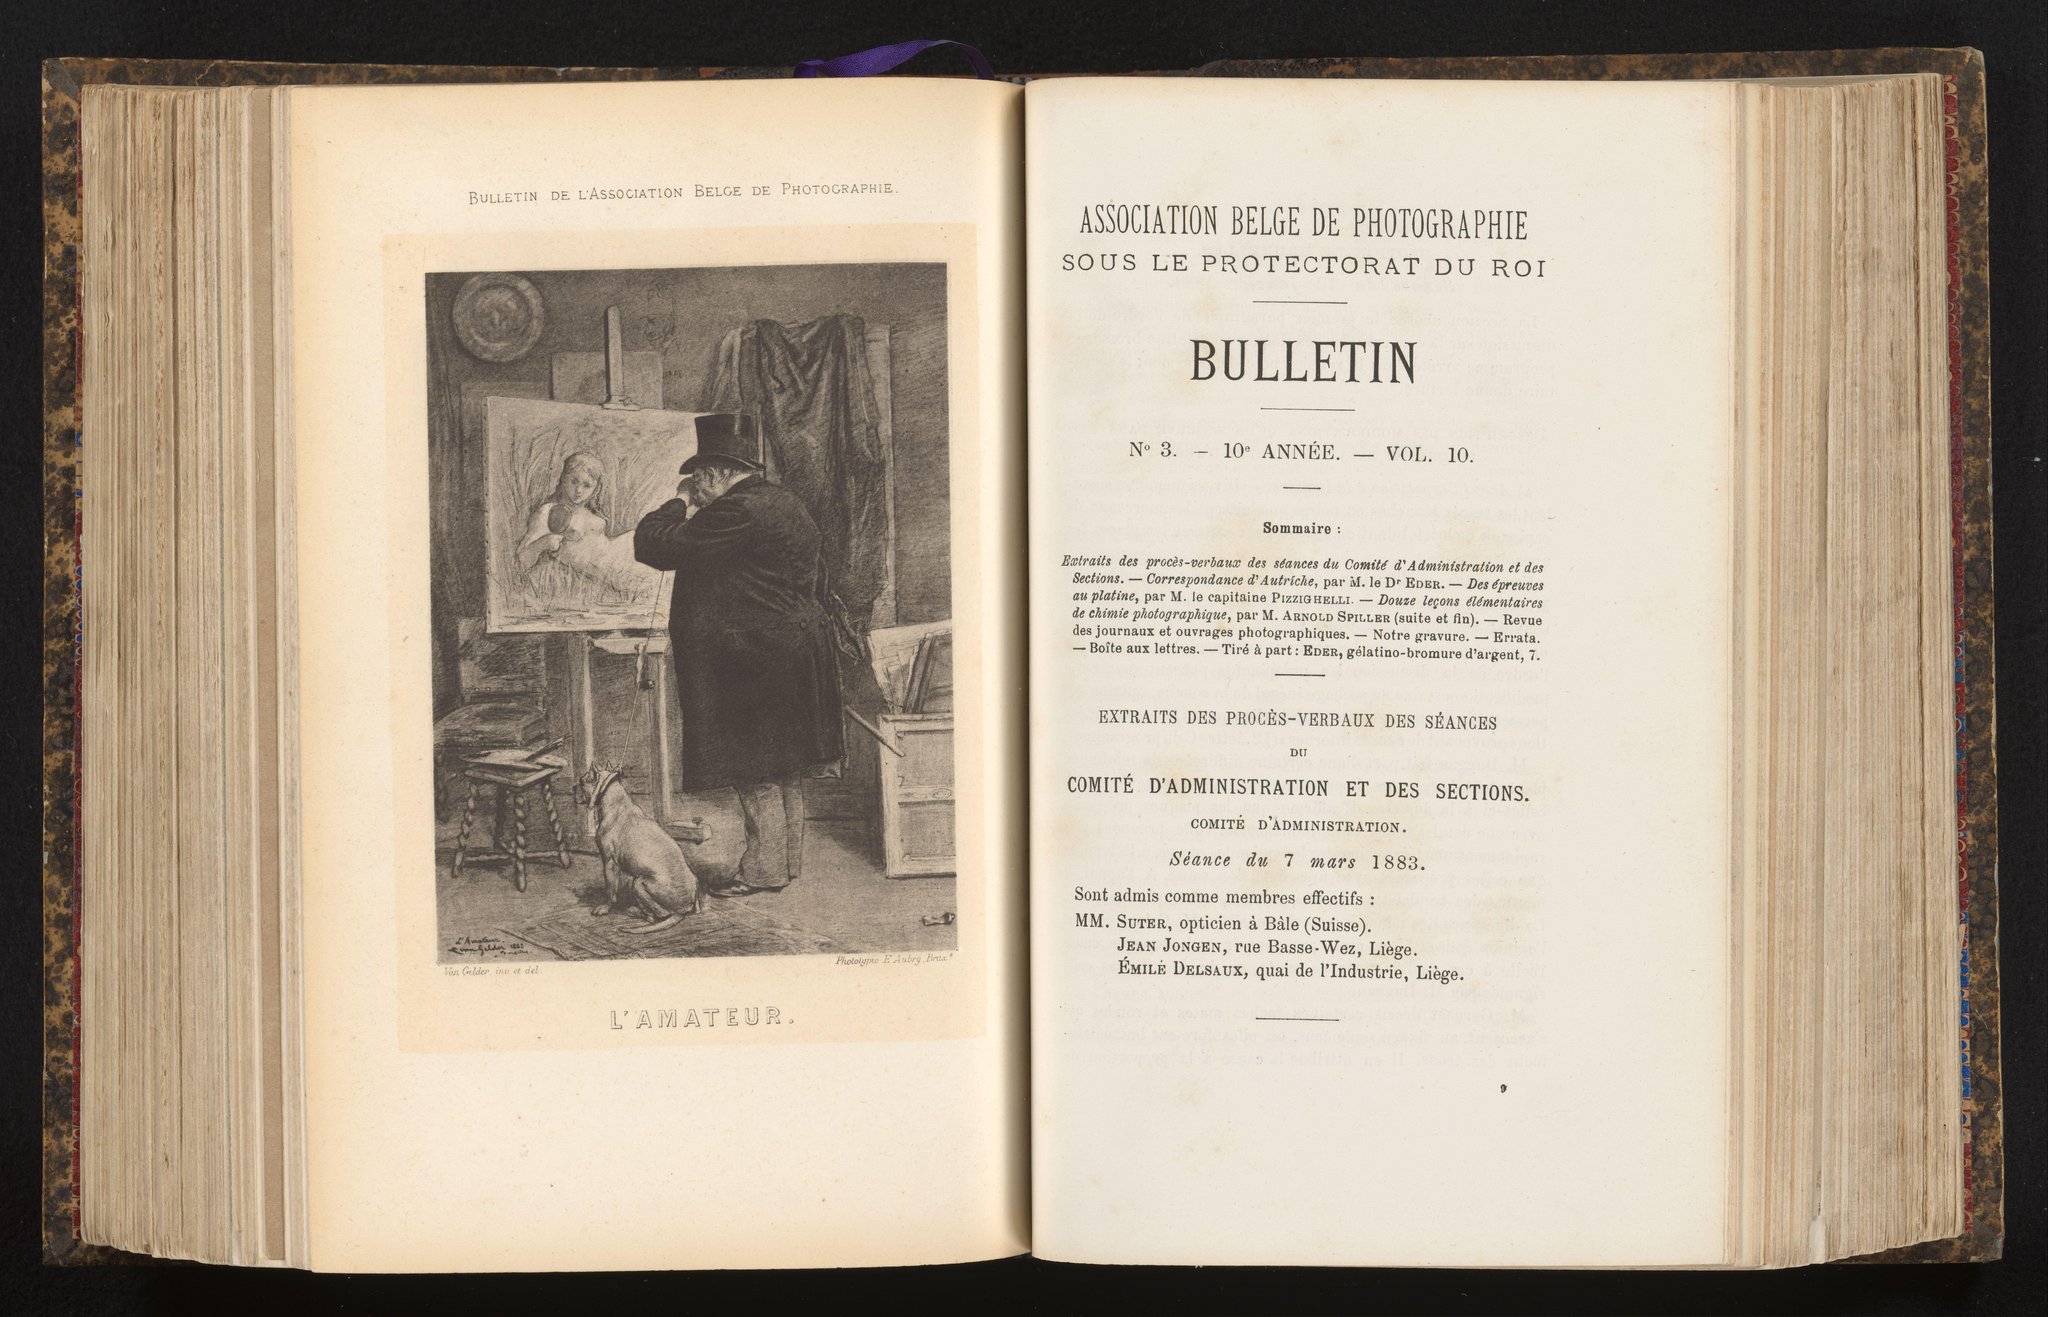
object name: page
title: Reproductie van een ontwerp met de voorstelling van een schilder in zijn atelier door Eugène van Gelder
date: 1878-1883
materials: paper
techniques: photograph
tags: historical persons, workshop, studio ~ painter, painting, drawing and the graphic arts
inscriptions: inscription: ‘Bulletin de l'Association belge de Photographie’